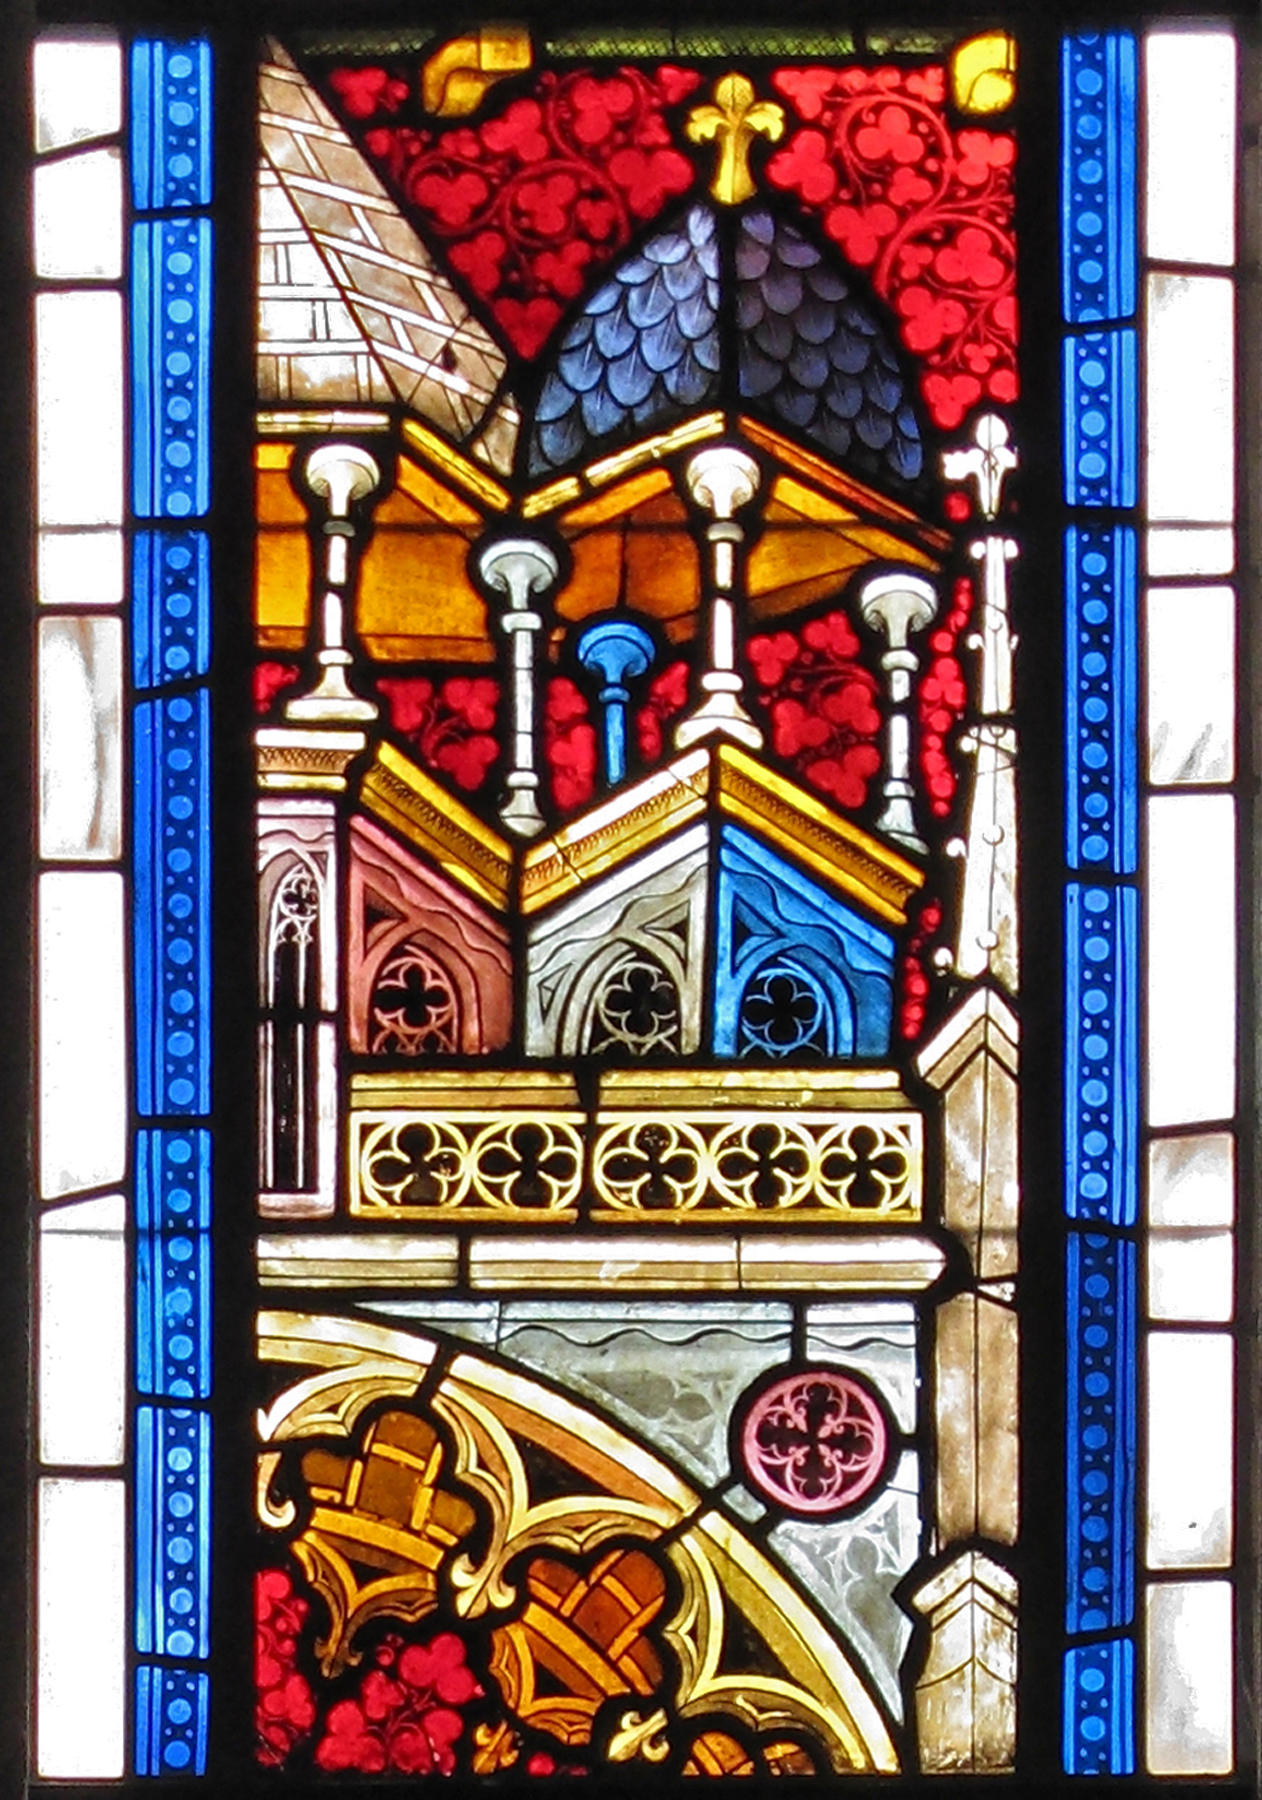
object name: panel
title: Architectural canopy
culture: austrian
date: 1390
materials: glass, metal, paint, pigment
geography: austria